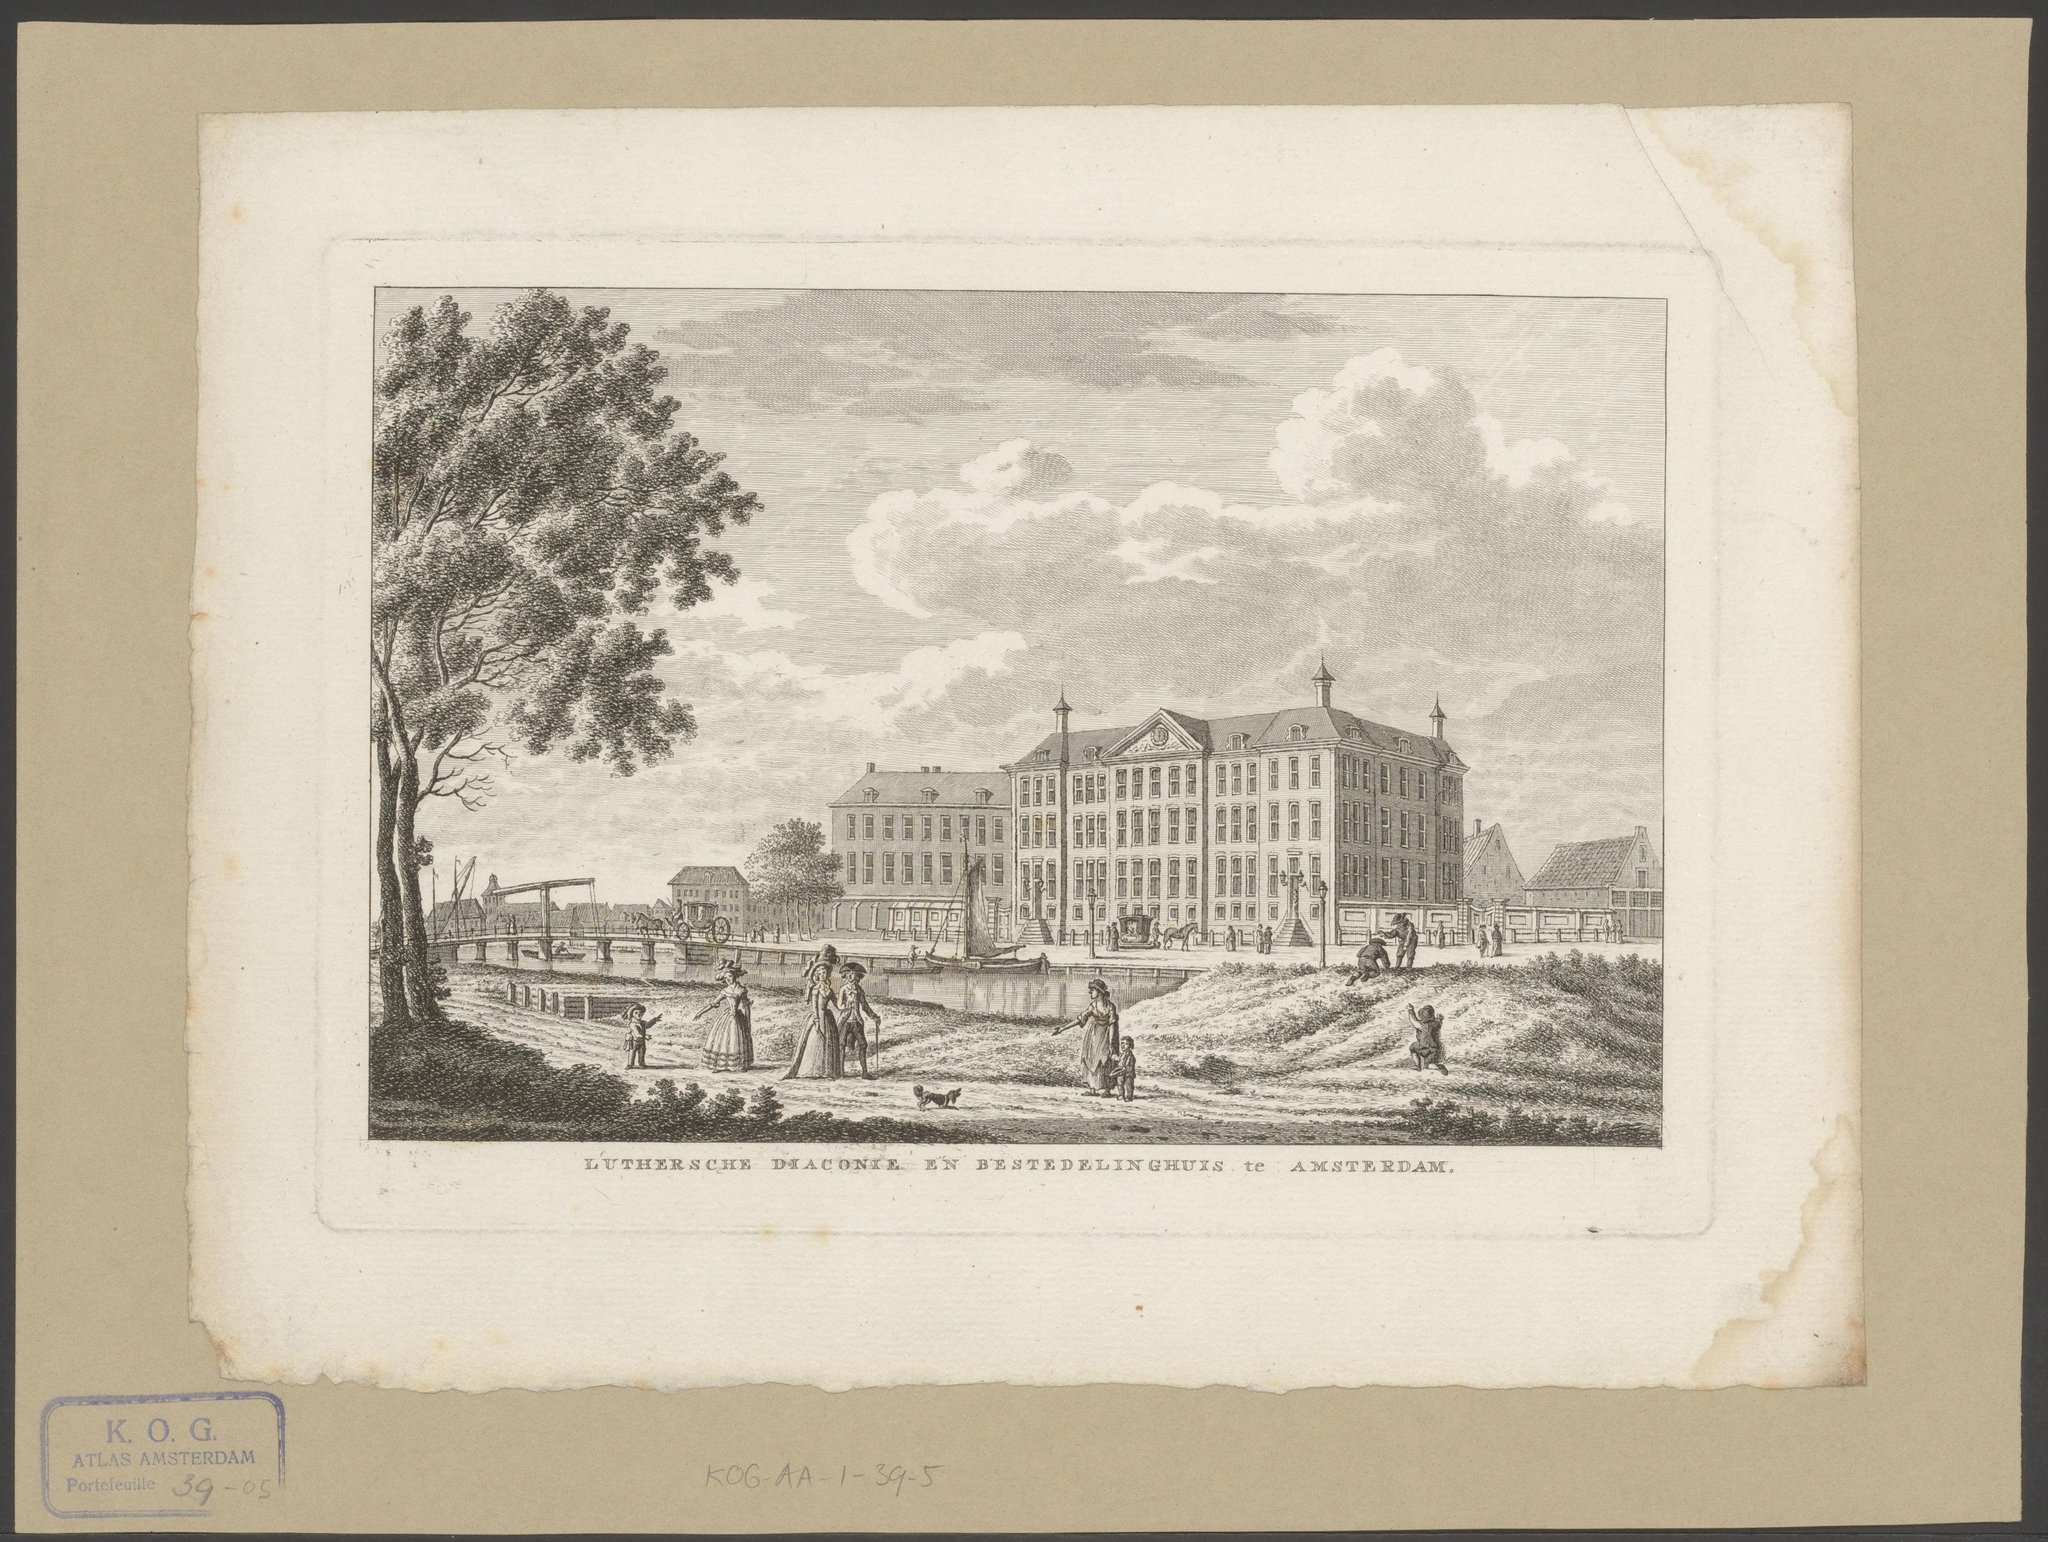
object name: print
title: Luthersche Diaconie en Bestedelinghuis te Amsterdam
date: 1786-1792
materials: paper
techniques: engraving, etching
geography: amsterdam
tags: canals, waters (in city) (+ city(-scape) with figures, staffage), old-people's home, street (+ city(-scape) with figures, staffage)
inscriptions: collector's mark: Lugt 1641b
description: Prent mogelijk uit: Vaderlandsche gezichten, of afbeeldingen van den tegenwoordigen staat der Vereenigde Nederlanden (…). Amsterdam: Hendrik Gartman, Willem Vermandel en Jan Willem Smit, [1786-1792]. Deze publicatie is uitgegeven in afleveringen met ieder een eigen bifolium en inhoudsopgave. Alle prenten uit deze publicatie zijn gegraveerd door Carel Frederik Bendorp (I) en, in de meeste gevallen, gebaseerd op tekeningen van Jan Bulthuis.